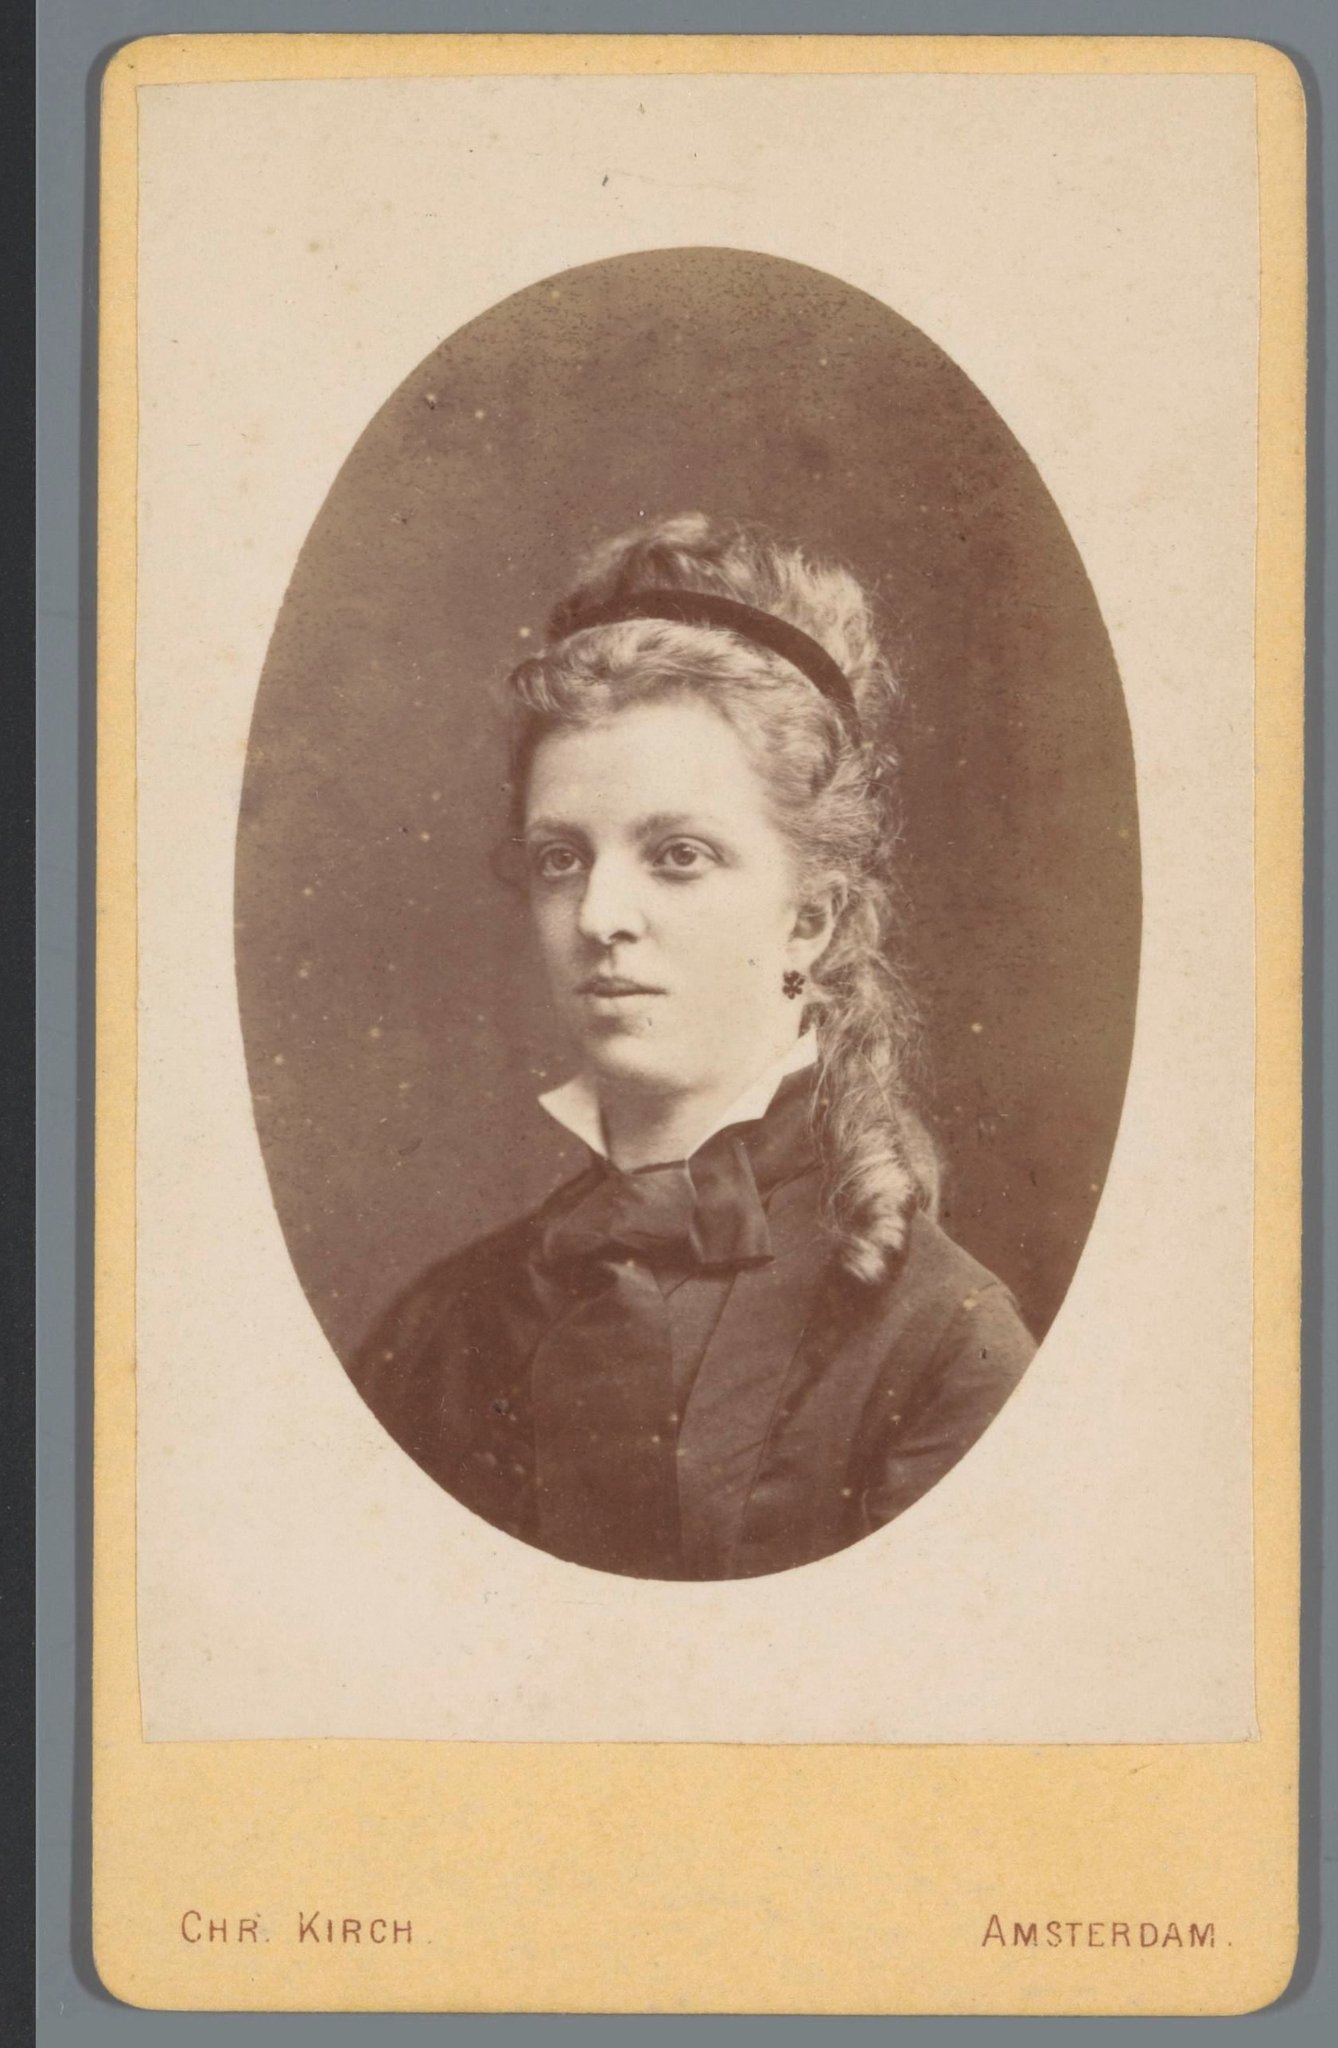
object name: carte de visite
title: Portret van een onbekende jonge vrouw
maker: christian theodor kirch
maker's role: fotograaf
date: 1875-1881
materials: cardboard, paper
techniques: albumen print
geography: amsterdam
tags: adolescent, young woman, maiden, anonymous historical person portrayed, amsterdam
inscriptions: inscription: ‘Photographie/ Chr. Kirch/ Amsterdam/ 179, Kalverstraat over den Heyligenweg./ Het cliché wordt voor verdere bestellingen/ bewaard.’, inscription: ‘Chr. Kirch. Amsterdam.’